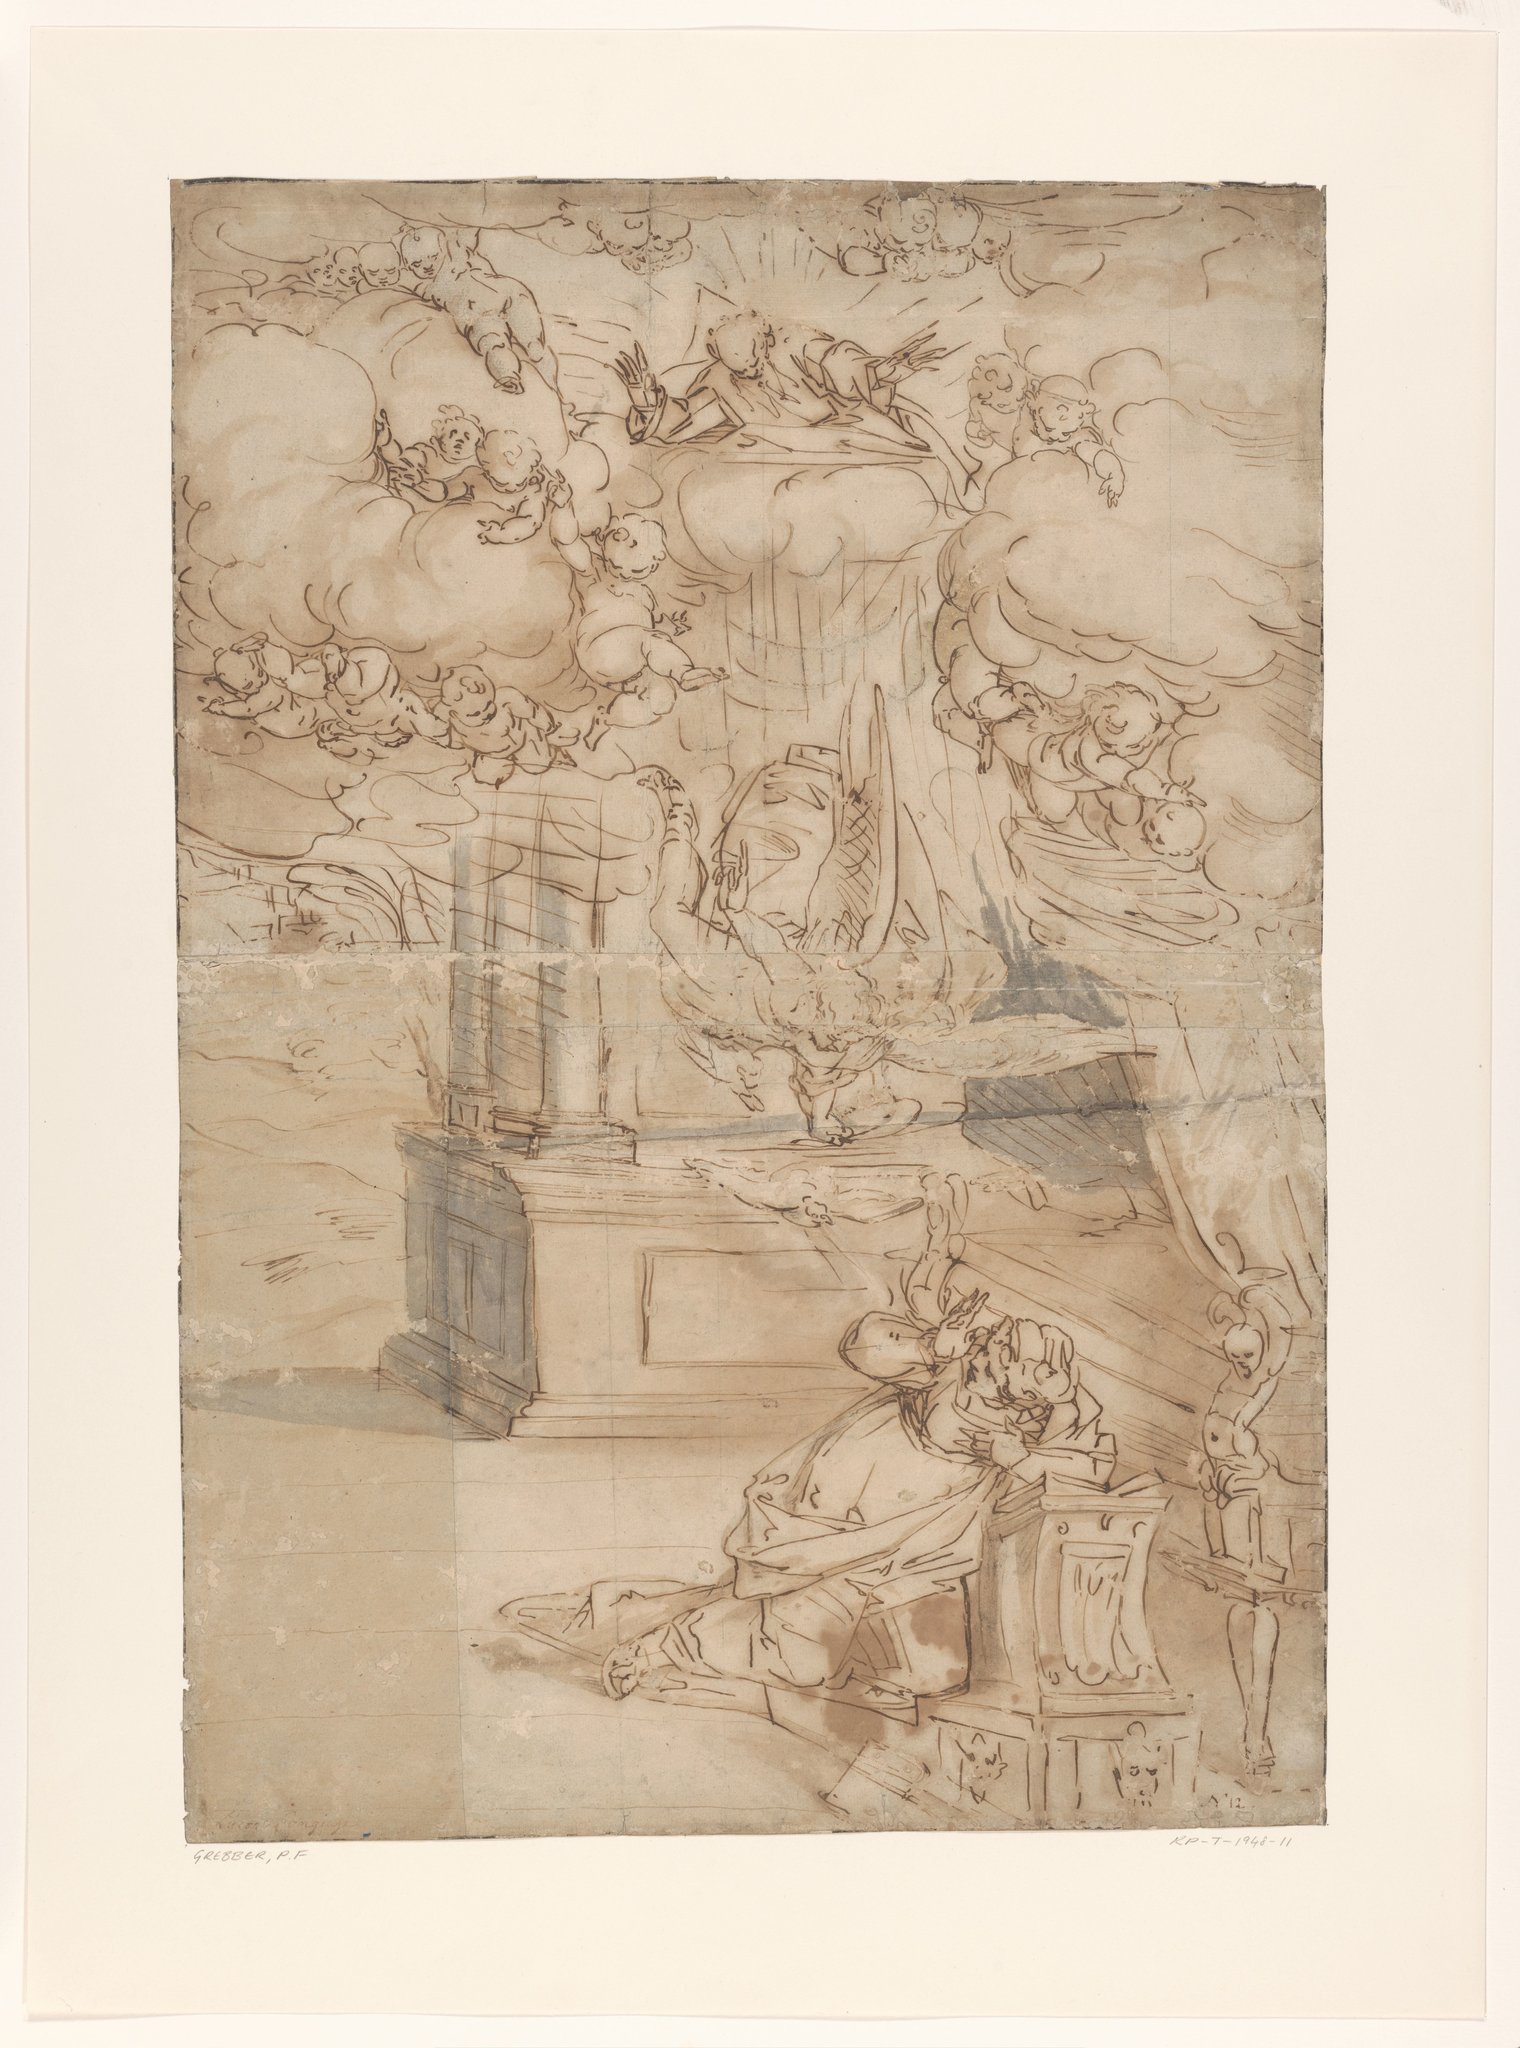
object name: drawing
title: De verkondiging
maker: luca cambiaso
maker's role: draughtsman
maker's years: 1527-1585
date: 1537-1585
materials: chalk, ink, paper, pencil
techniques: brush, pen